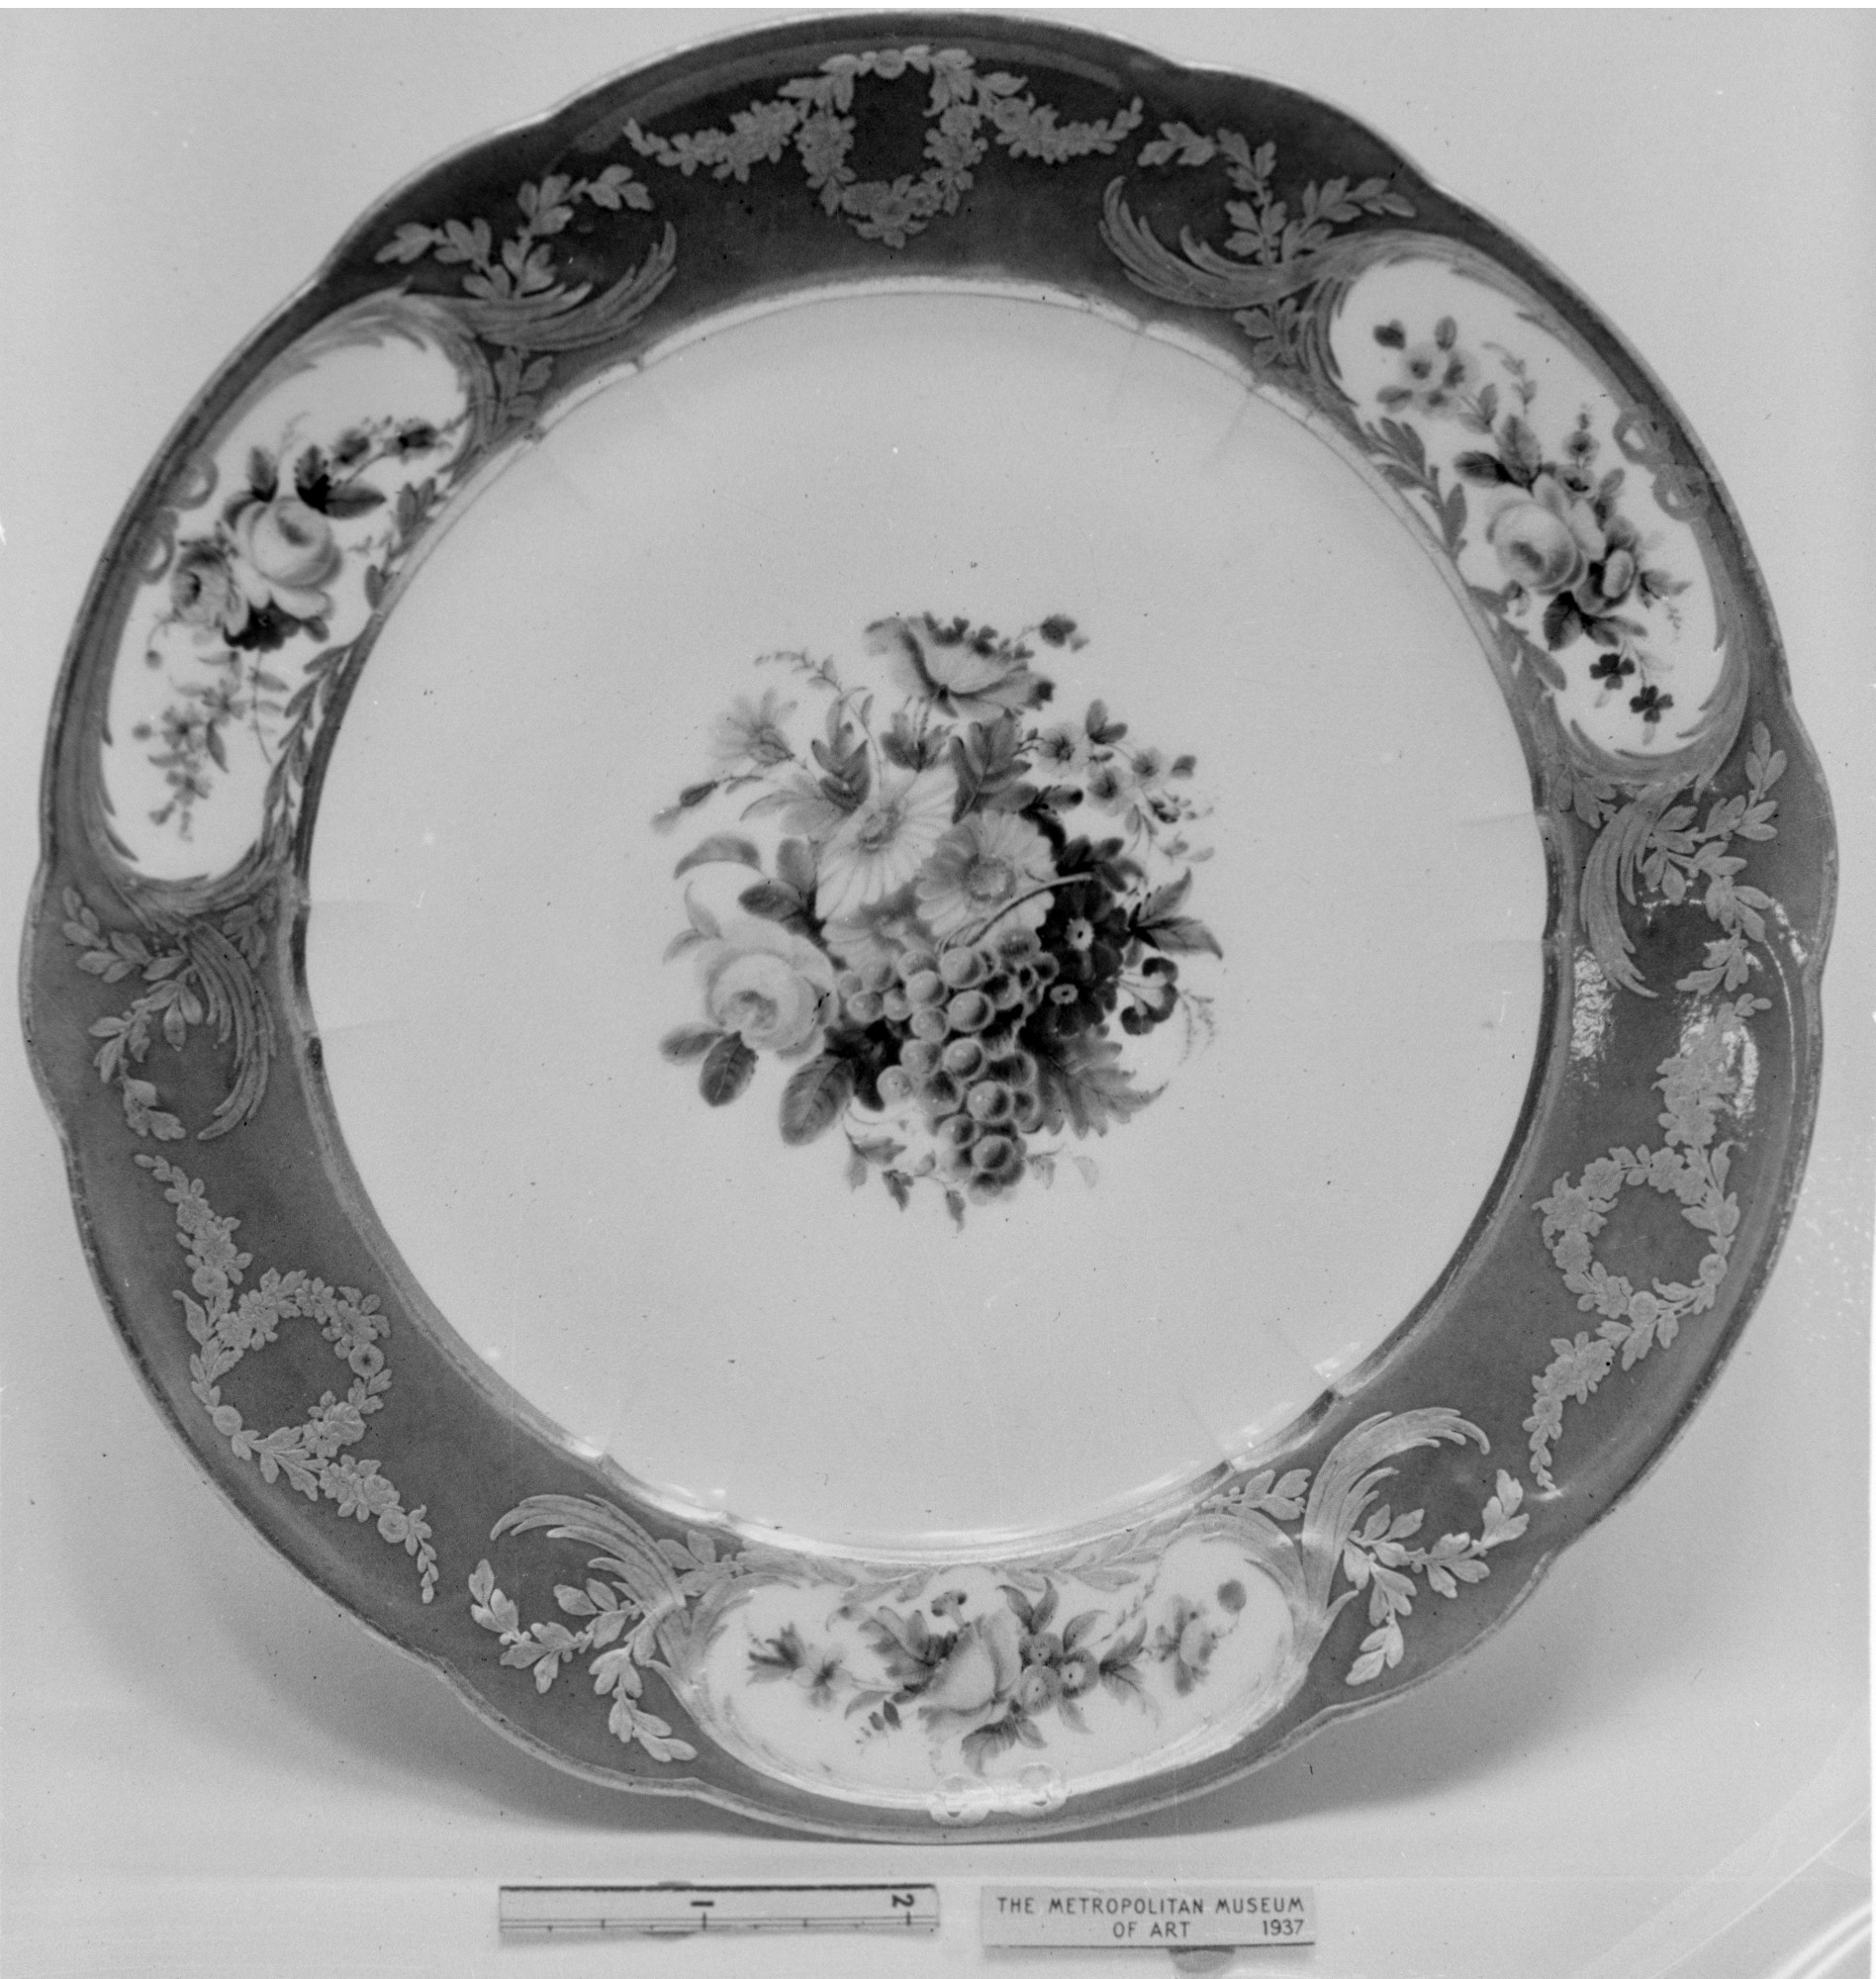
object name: plate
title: Plate (part of a service)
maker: sèvres manufactory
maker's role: manufactory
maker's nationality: french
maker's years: 1740-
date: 1777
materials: soft paste porcelain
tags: grapes,flowers